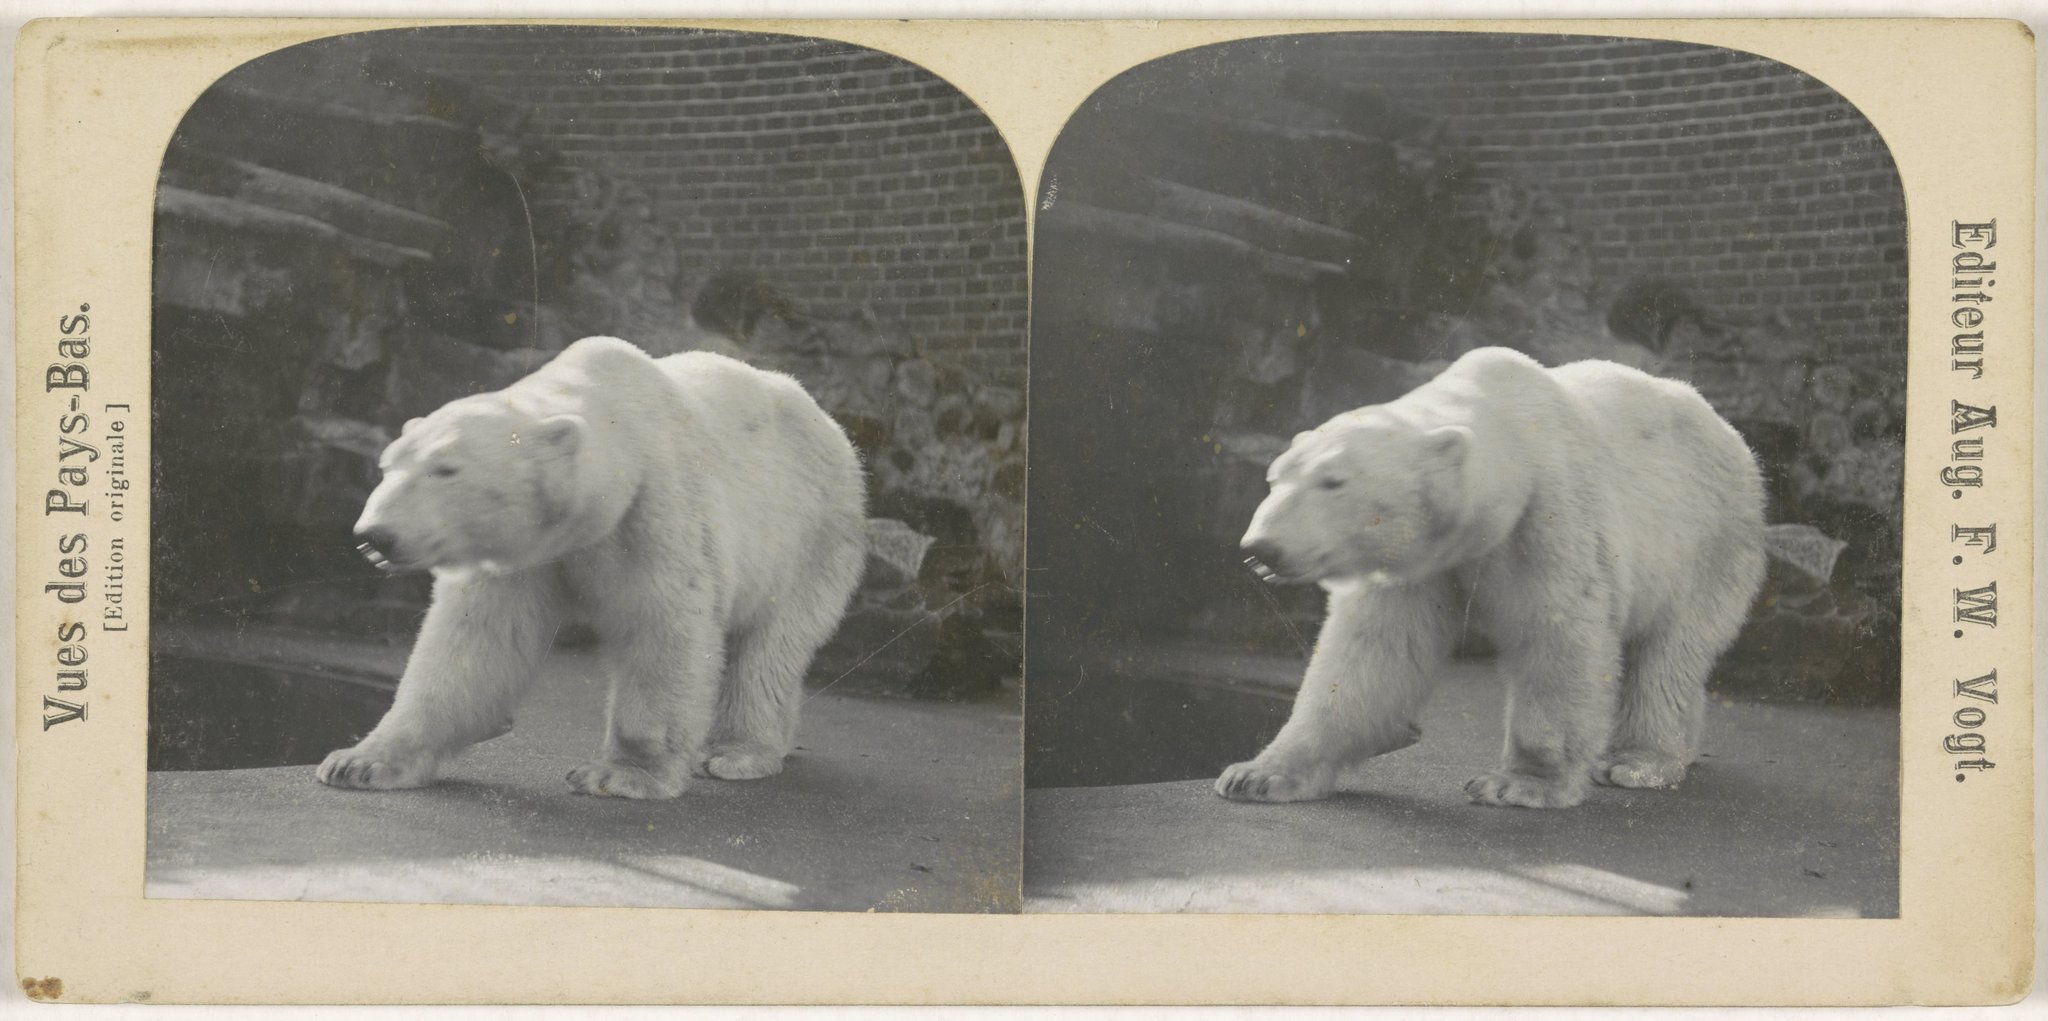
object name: stereograph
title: IJsbeer in dierentuin (Artis?), Nederland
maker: august frederik willem vogt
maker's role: fotograaf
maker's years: 1871-1922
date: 1920-1940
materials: cardboard, paper, photographic support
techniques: gelatin silver print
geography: netherlands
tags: netherlands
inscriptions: annotation: ‘Willem Hartkamp / b/a IJsberen...’, inscription: ‘€ 6,-’